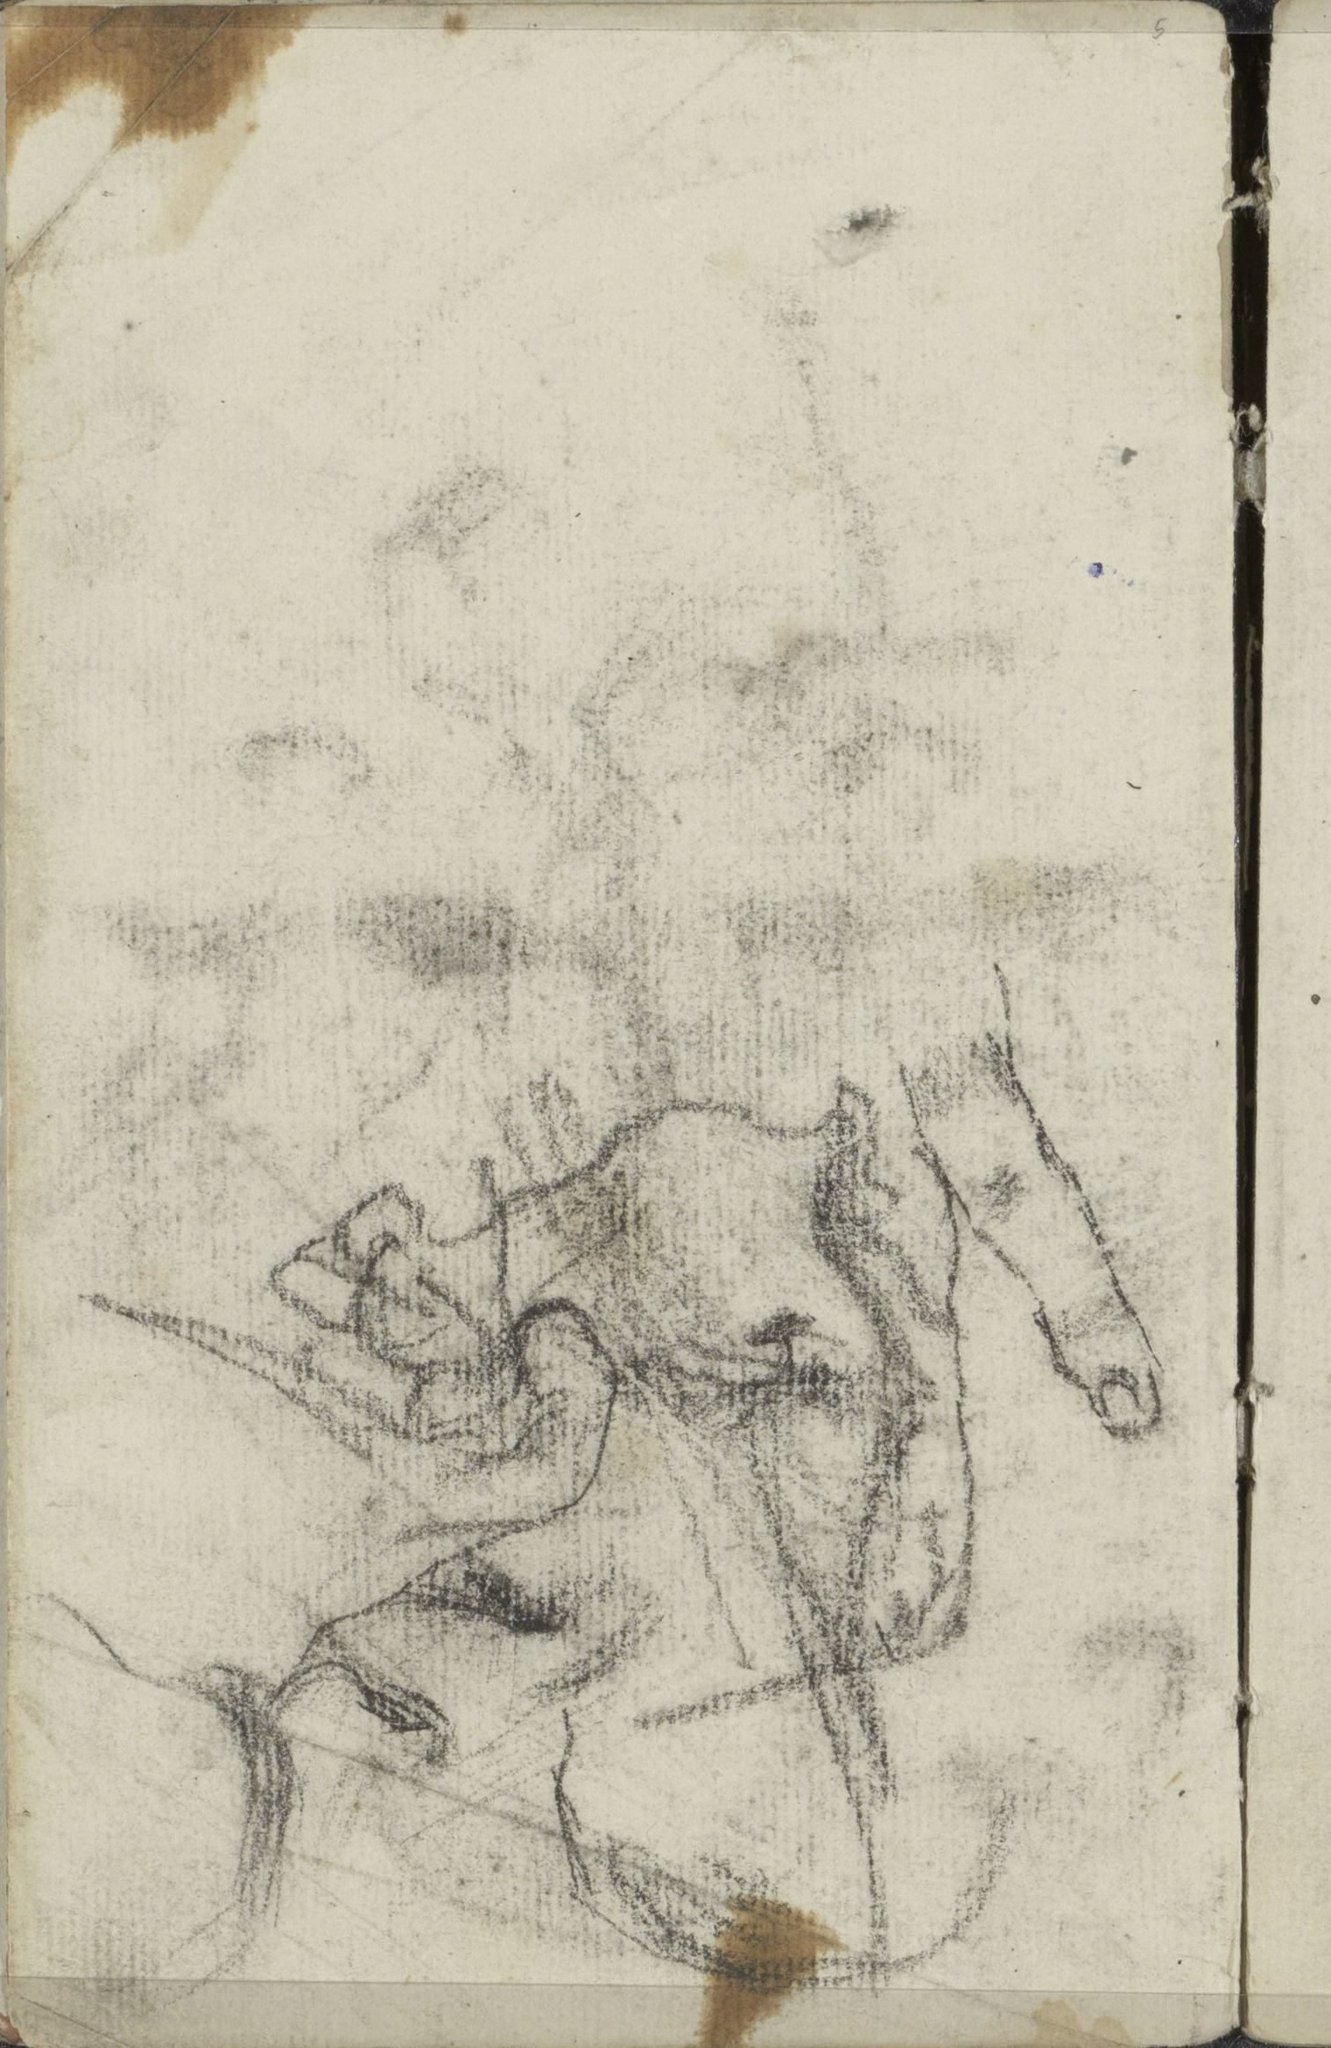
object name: sketchbook leaf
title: Handen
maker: george hendrik breitner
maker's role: draughtsman, painter, print maker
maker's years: 1857-1923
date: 1883-1885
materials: chalk, paper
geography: the hague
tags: hand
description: Pagina 5 uit een schetsboek met 17 bladen.